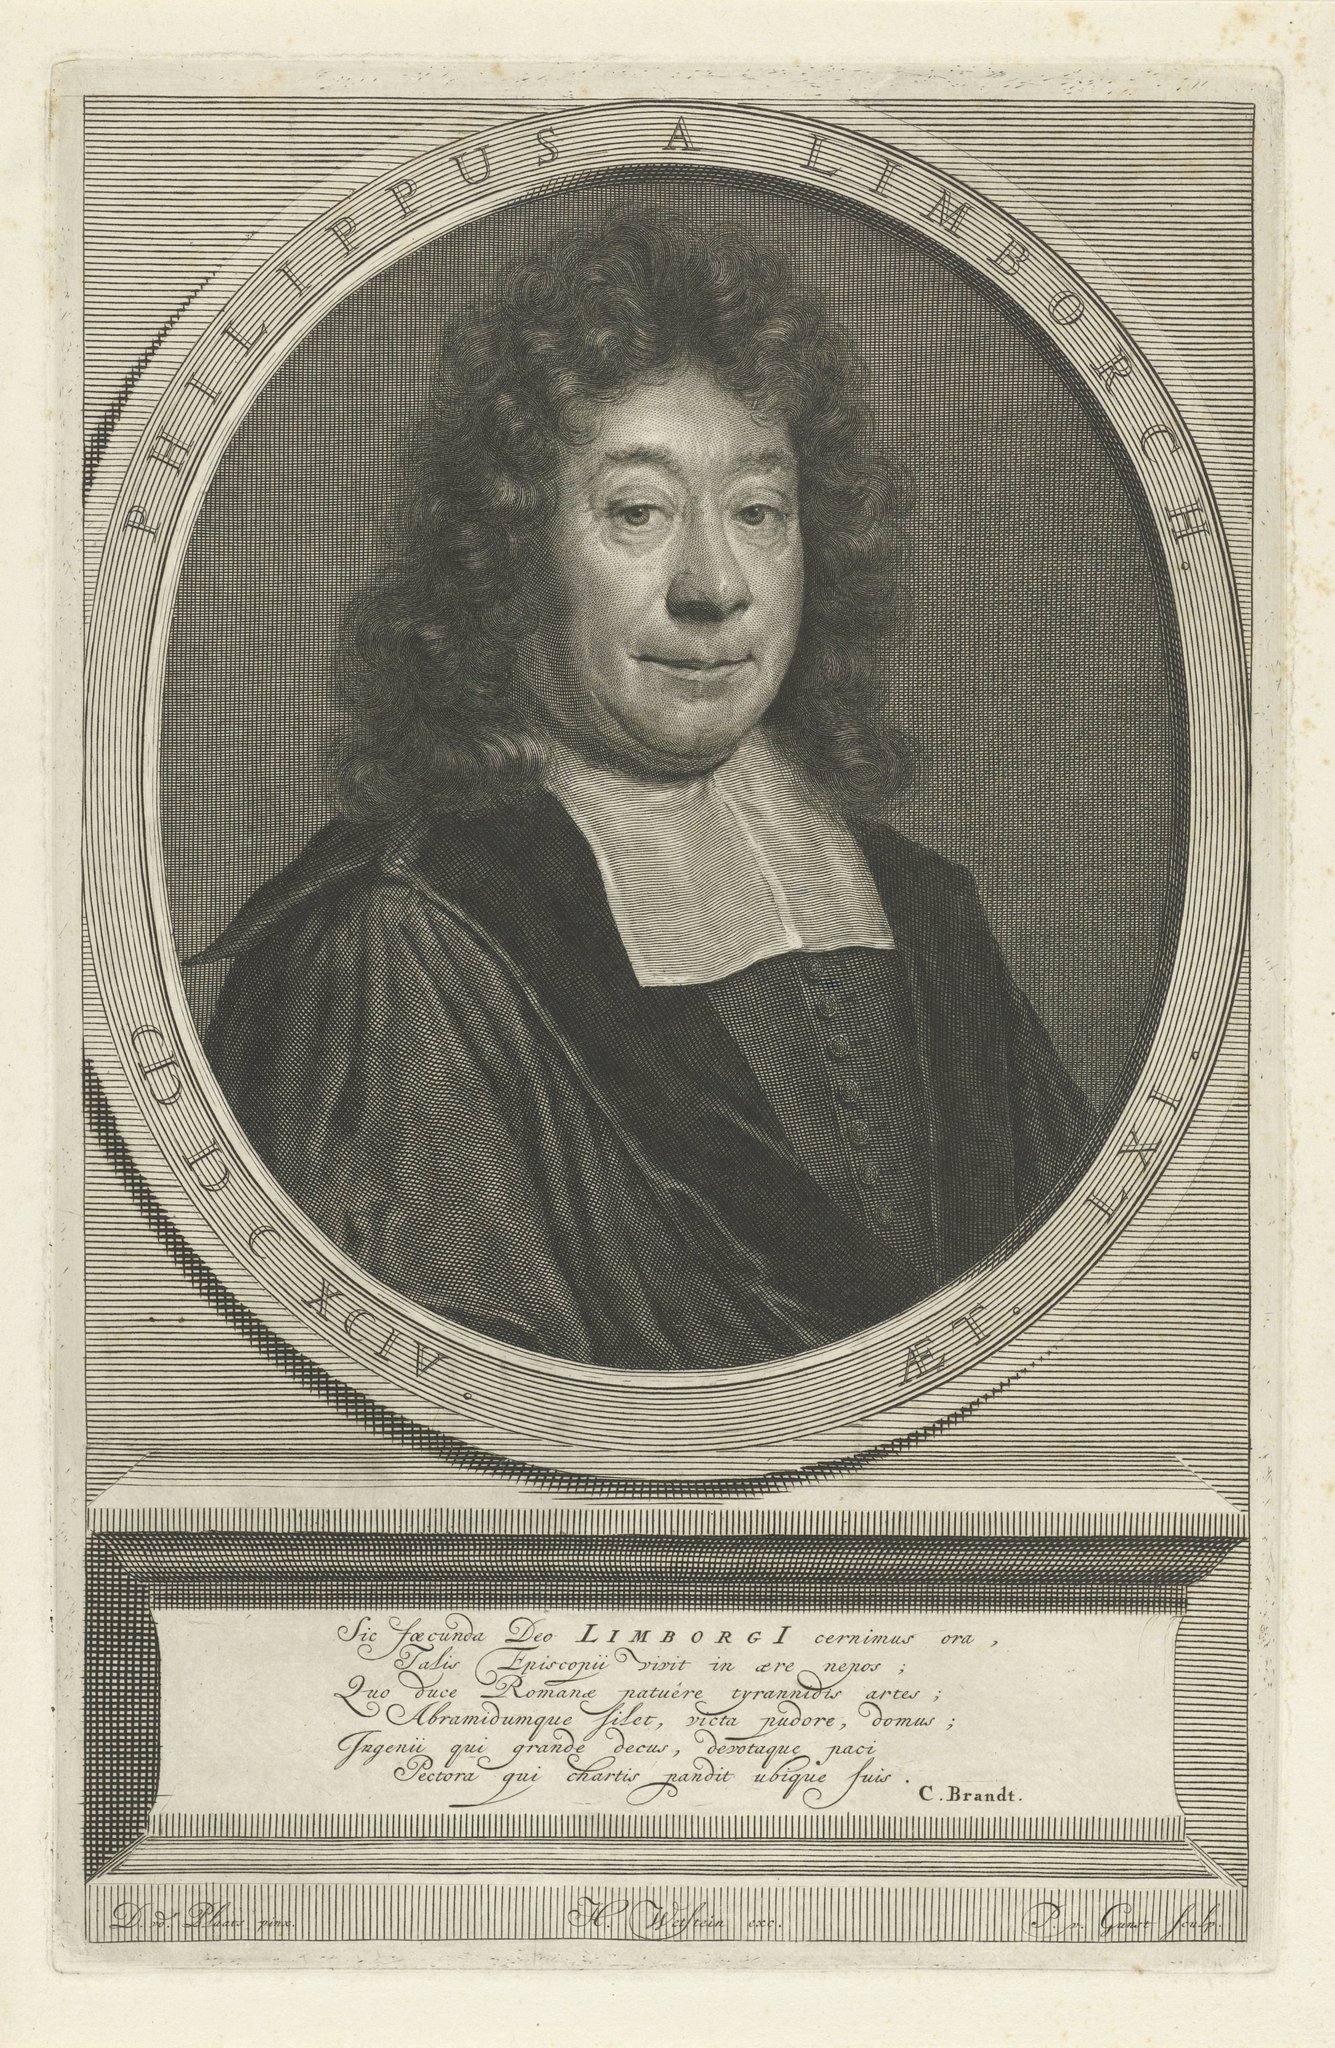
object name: print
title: Portret van Philippus van Limborch op 61-jarige leeftijd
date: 1695-1731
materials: paper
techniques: engraving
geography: amsterdam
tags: theoloog, philippus van limborch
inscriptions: collector's mark: Lugt 2228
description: Philippus van Limborch op 61-jarige leeftijd. Amsterdamse predikant en hoogleraar van de remonstranten. De prent heeft een Latijns onderschrift over zijn leven.